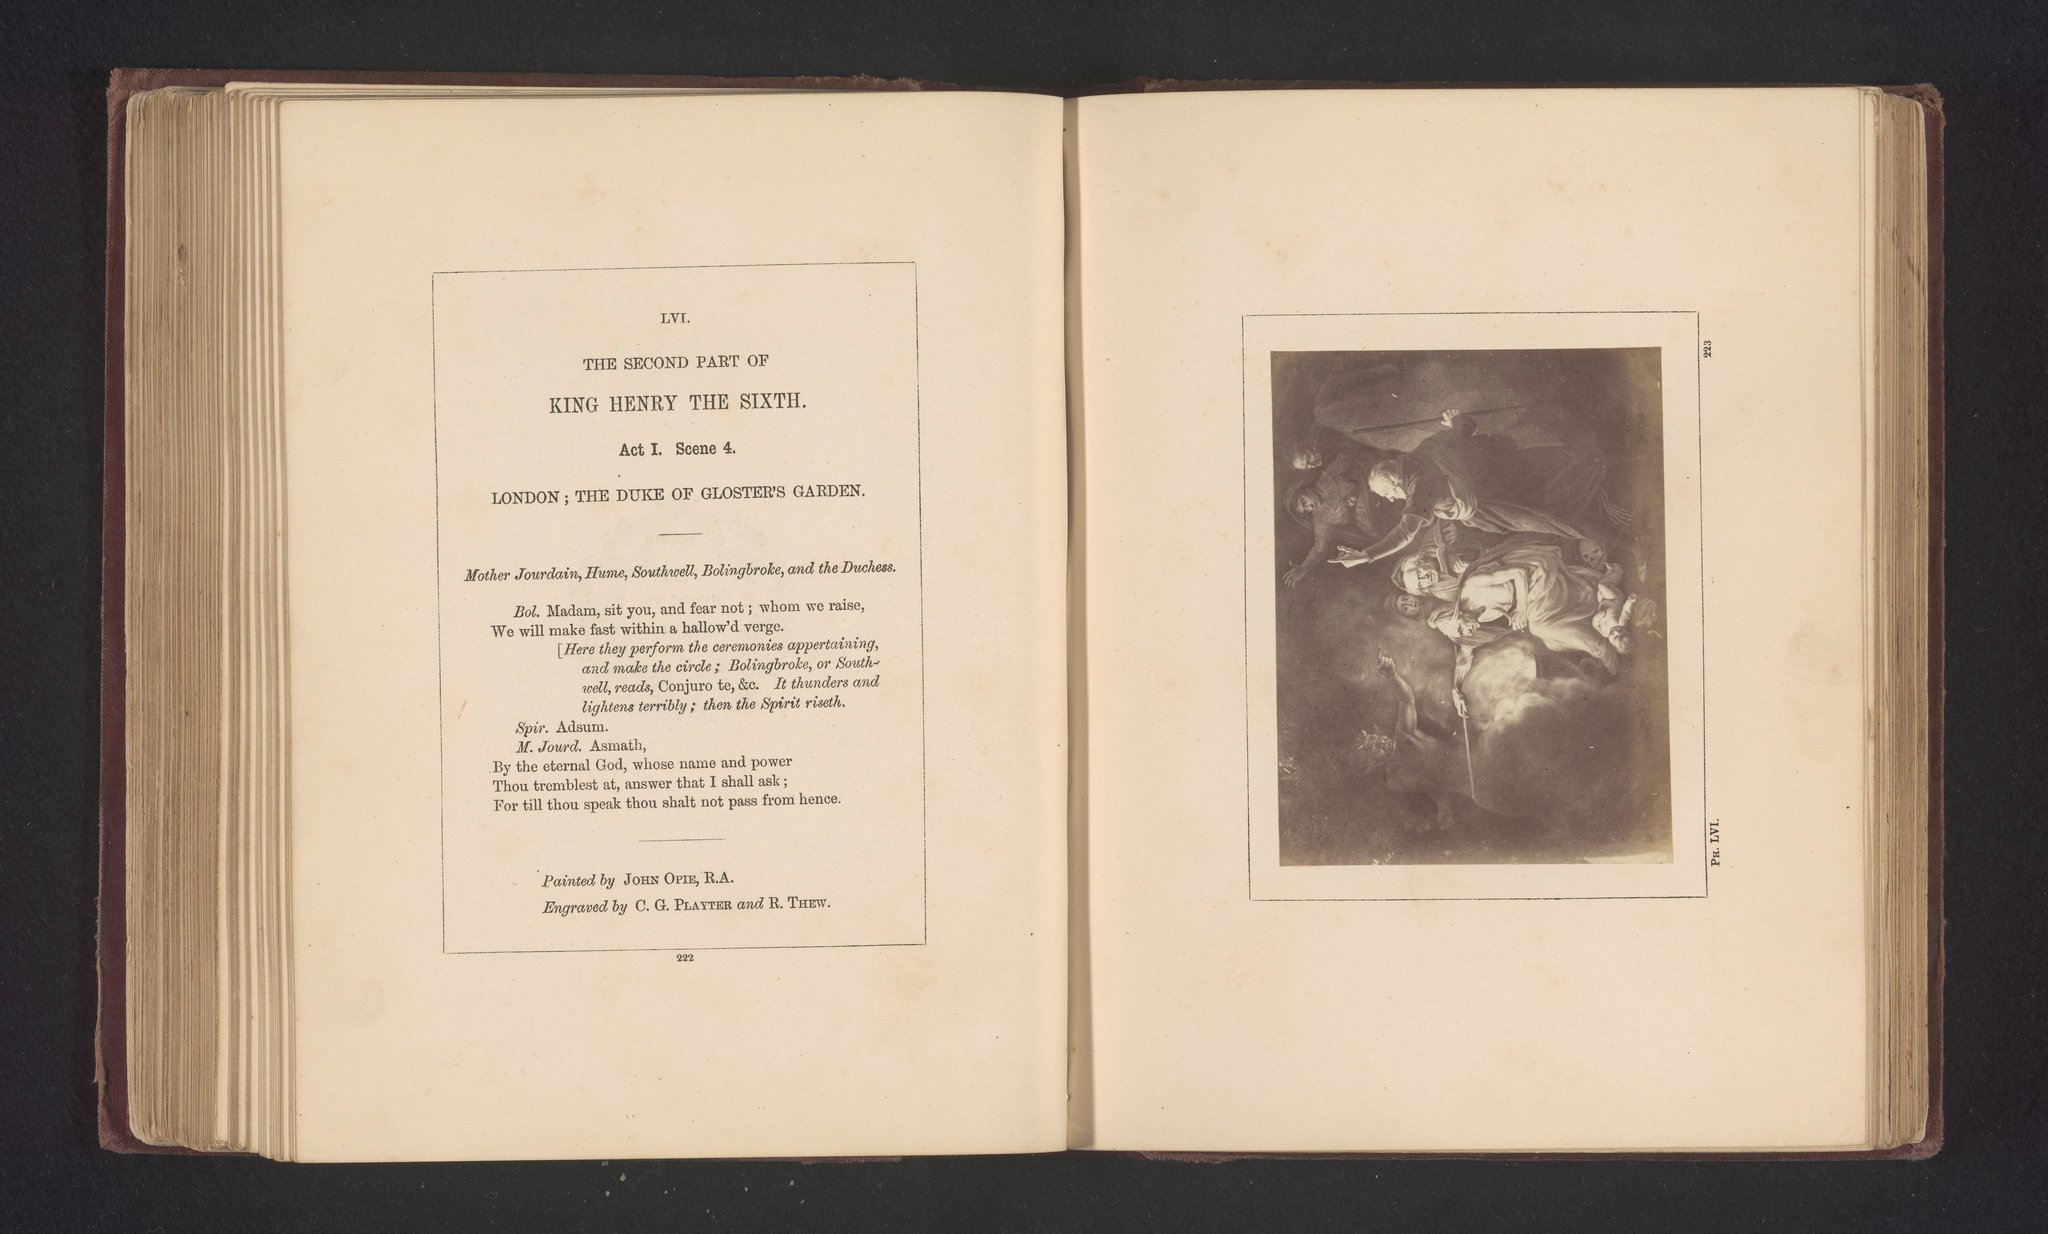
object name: reproduction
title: Fotoreproductie van een prent naar een schilderij door John Opie, voorstellend een scene uit Hendrik VI, deel 2 door William Shakespeare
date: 1854-1867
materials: photographic support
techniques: albumen print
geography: london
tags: specific works of literature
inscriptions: number: ‘Ph. LVI. 223’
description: Te zien is akte I, scene 4 met de heks Margaret Jourdain.